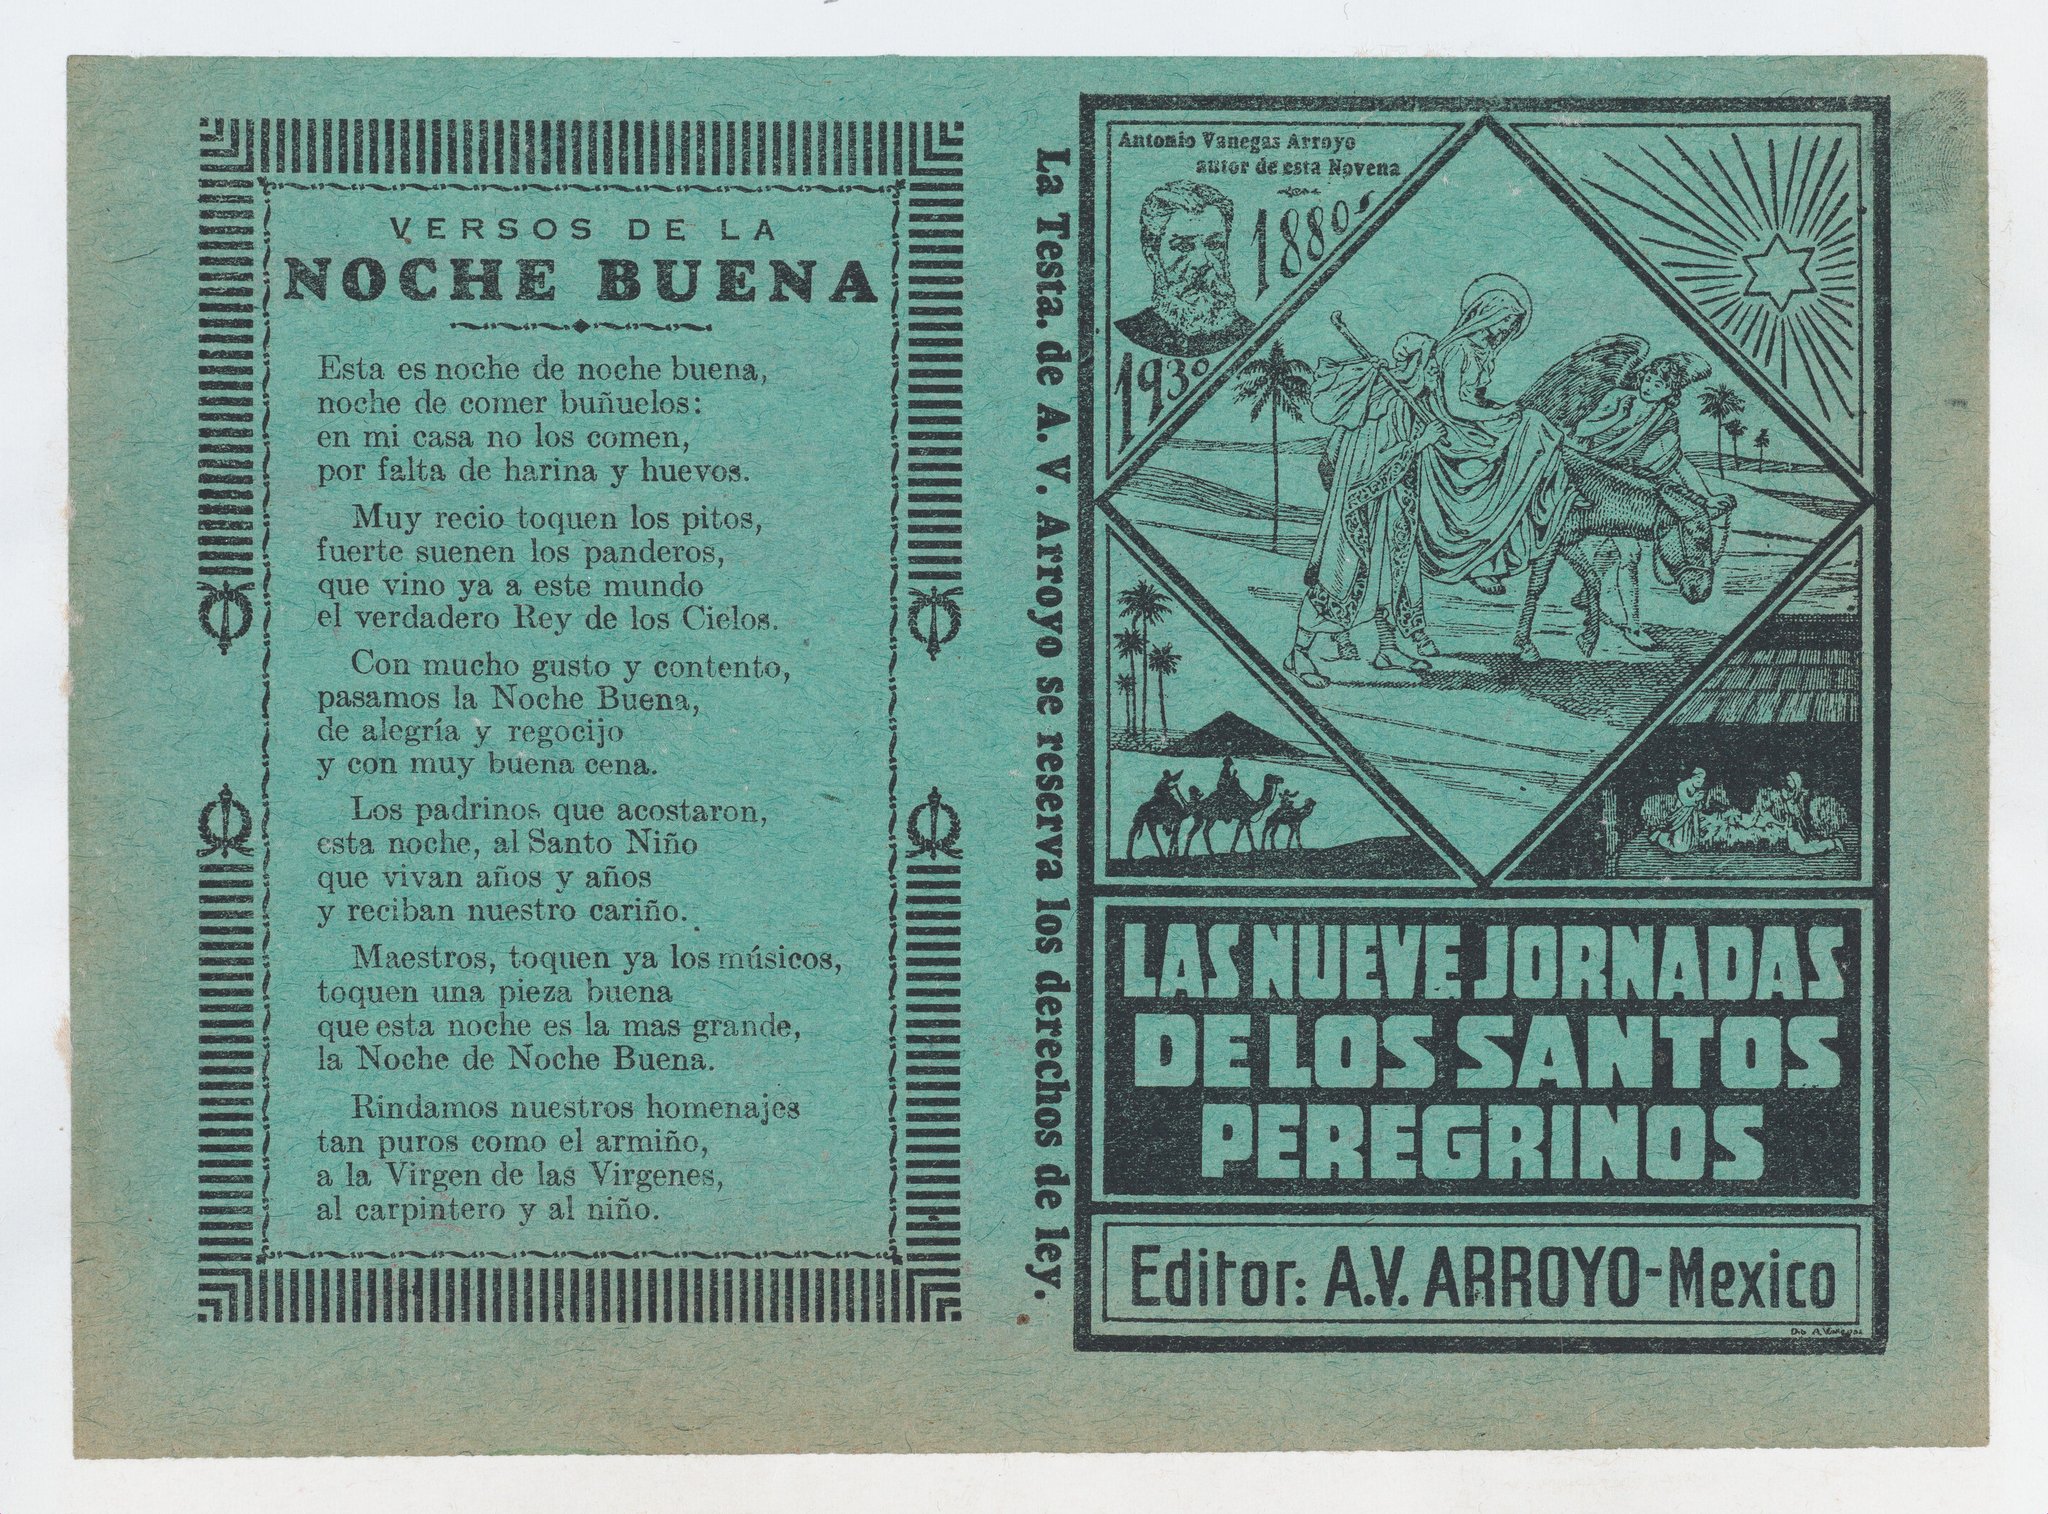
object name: print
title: Cover for 'Las Nueves Jornadas de los Santos Peregrinos', Mary on horseback and Joseph being guided through Egypt by an angel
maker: josé guadalupe posada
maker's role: artist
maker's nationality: mexican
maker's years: 1852-1913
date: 1880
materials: metal, paper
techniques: engraving, letterpress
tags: donkeys,angels,virgin mary